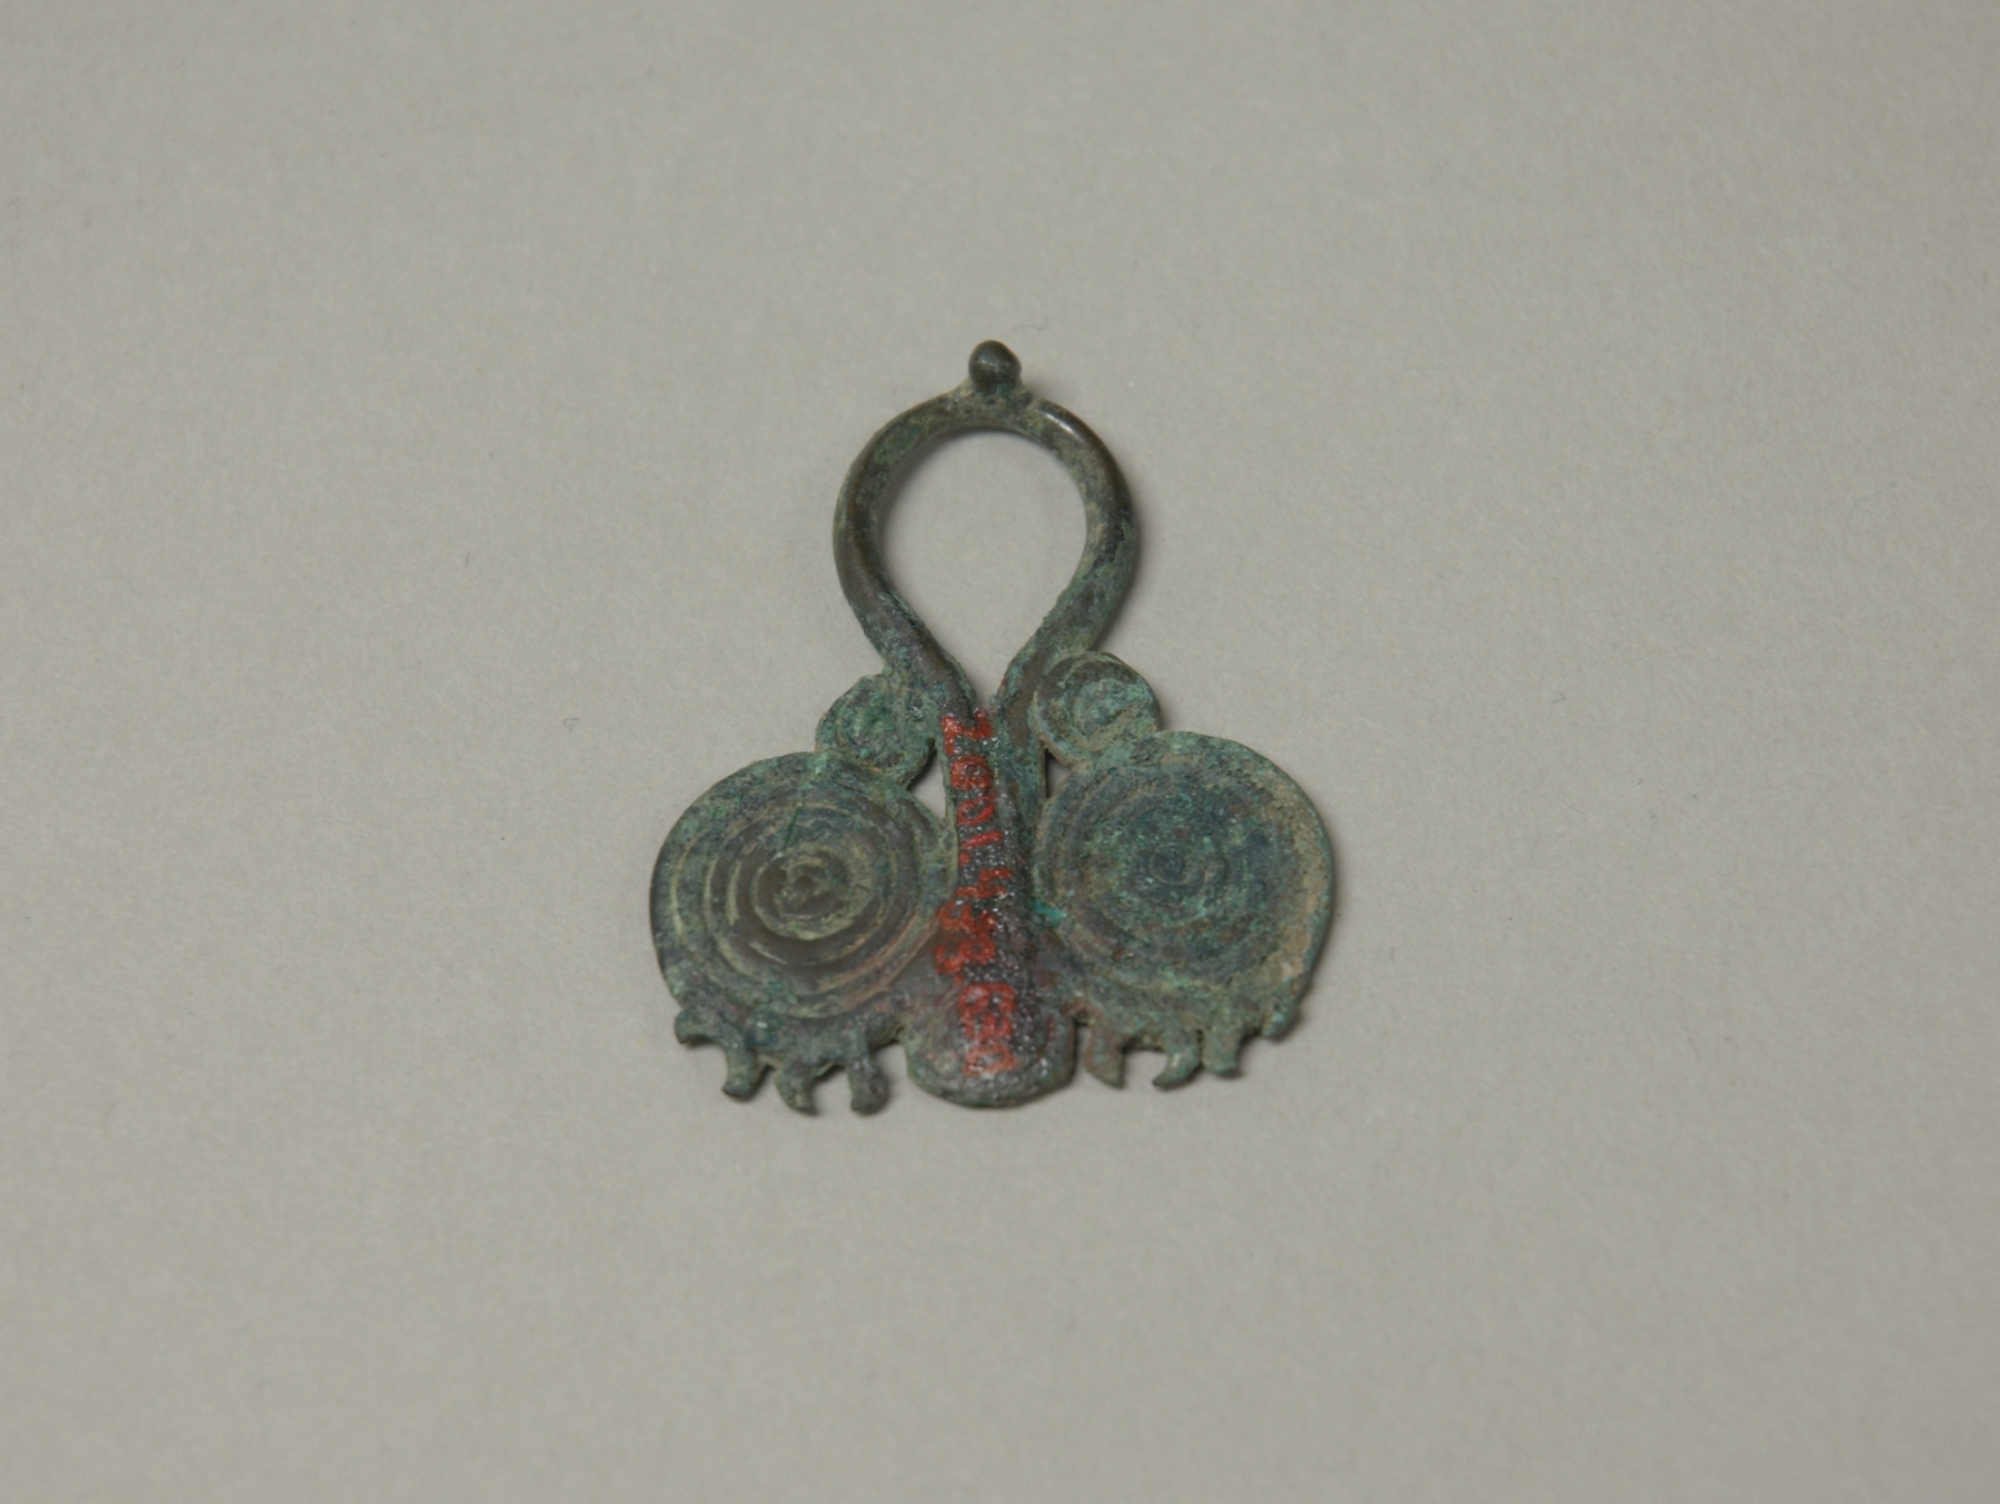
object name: pendant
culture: indonesian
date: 500 BCE-300 CE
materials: bronze